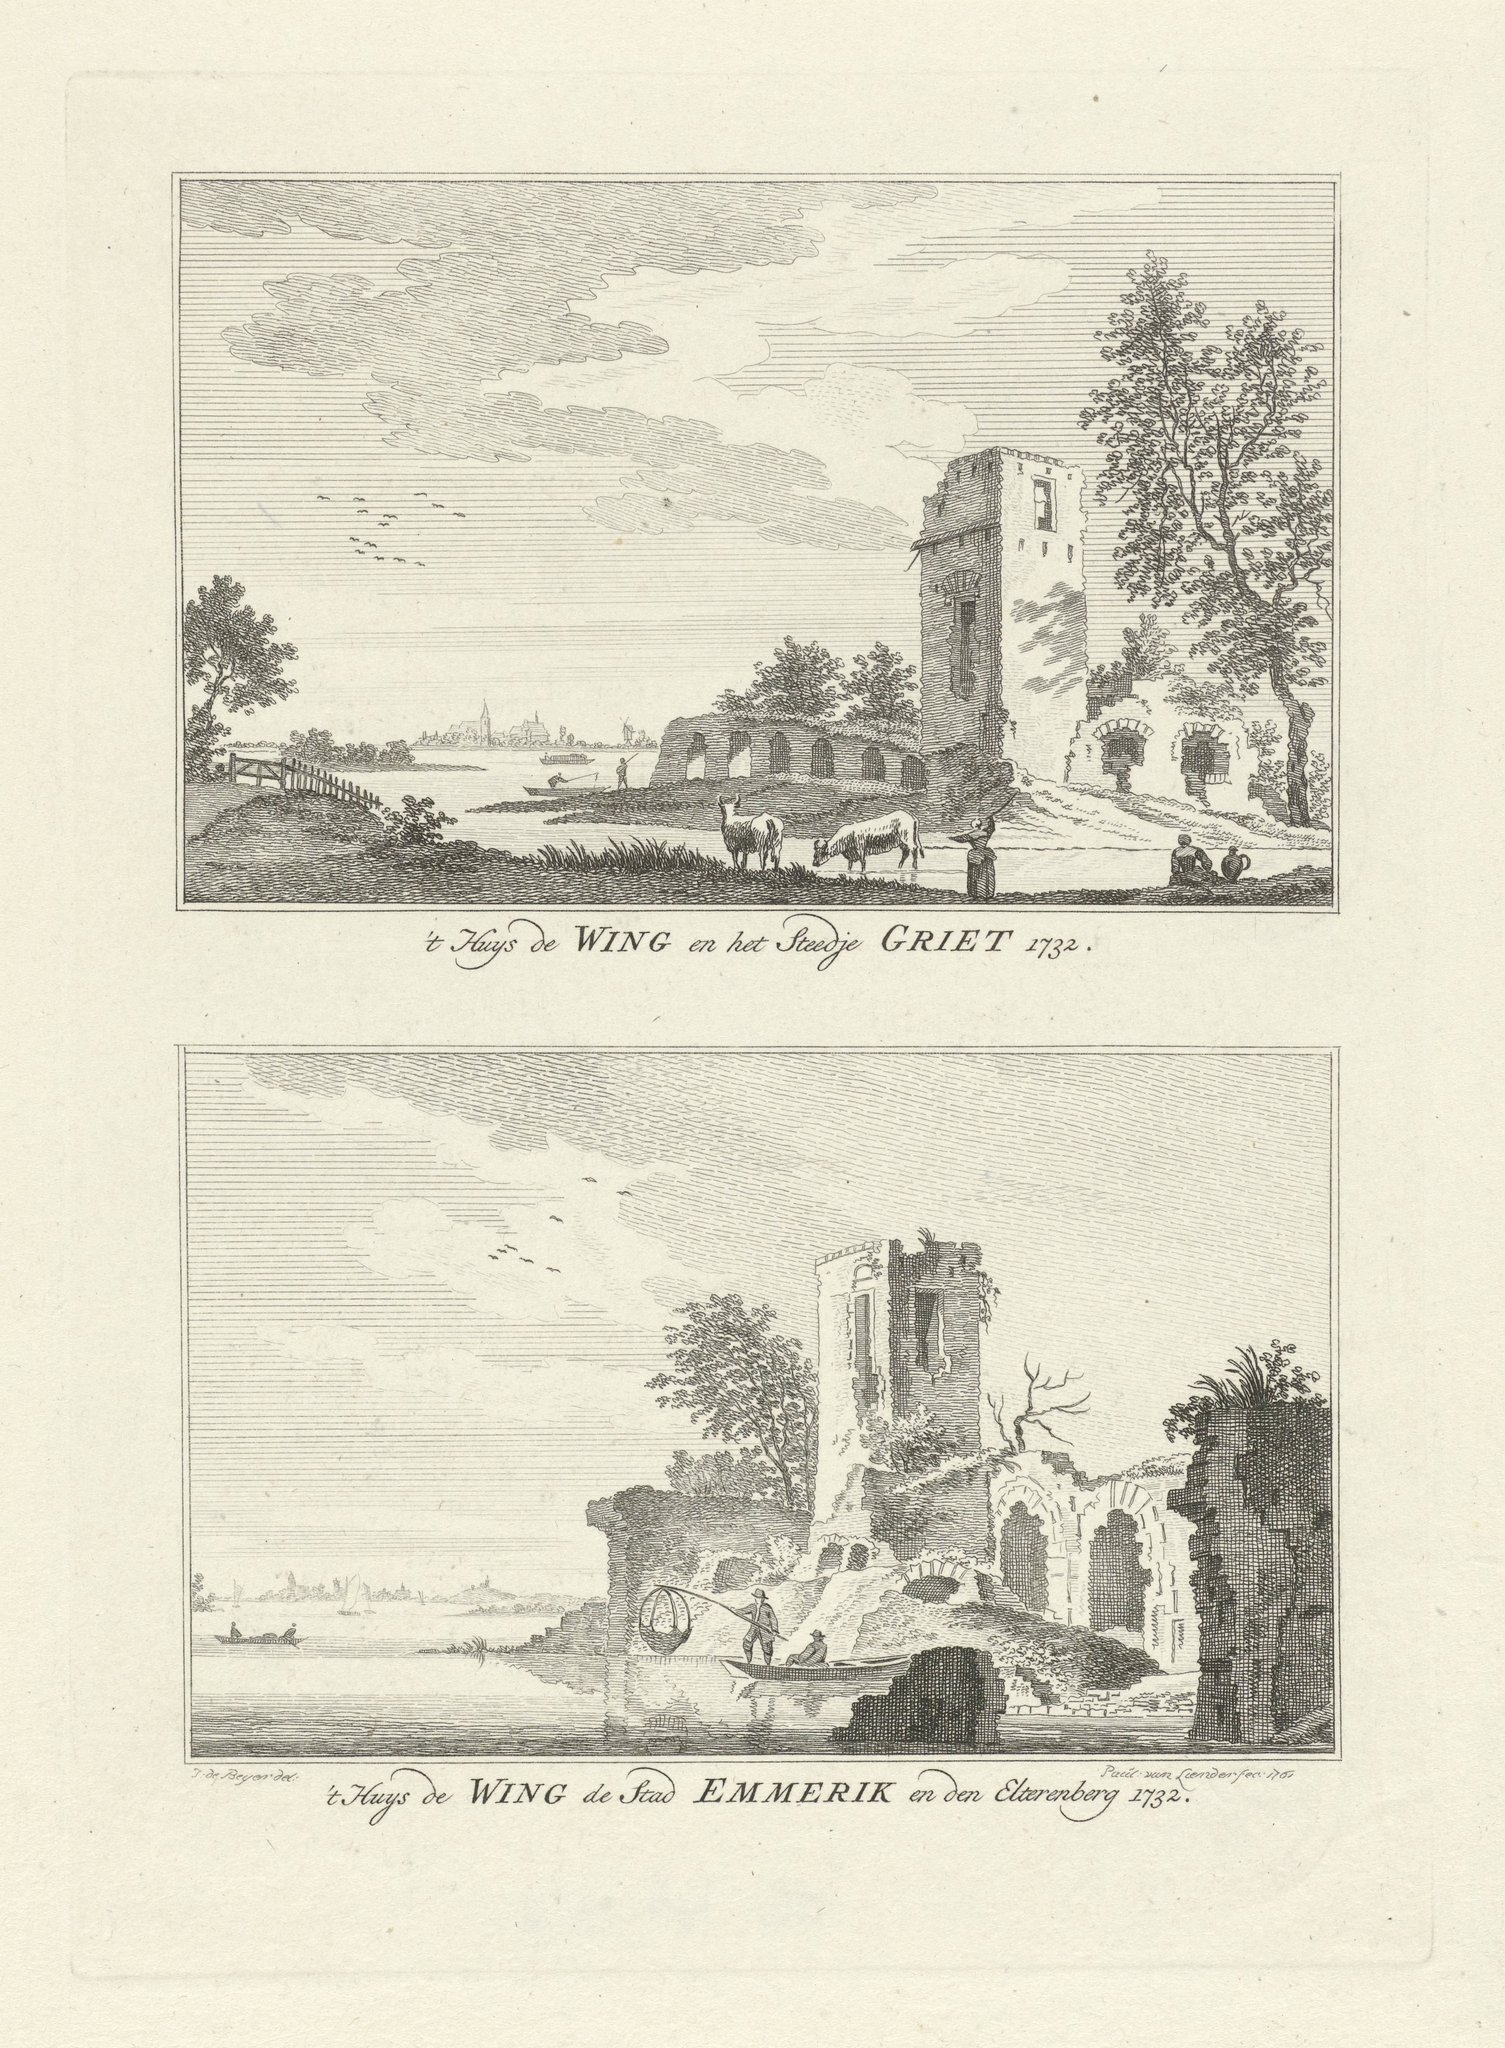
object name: print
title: Gezichten op Huis de Wing en de steden Grieth en Emmerik, 1732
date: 1761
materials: paper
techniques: etching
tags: landscape with ruins, prospect of city, town panorama, silhouette of city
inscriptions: collector's mark: Lugt 240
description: Twee voorstellingen van één plaat. Gezichten op de ruïne van Huis de Wing met in de verte de Duitse stad Grieth (boven) en Huis de Wing met in de verte de Duitse stad Emmerik en de Elterberg (onder). De prent maakt deel uit van een 100-delige serie met gezichten op dorpen en steden te Kleef.